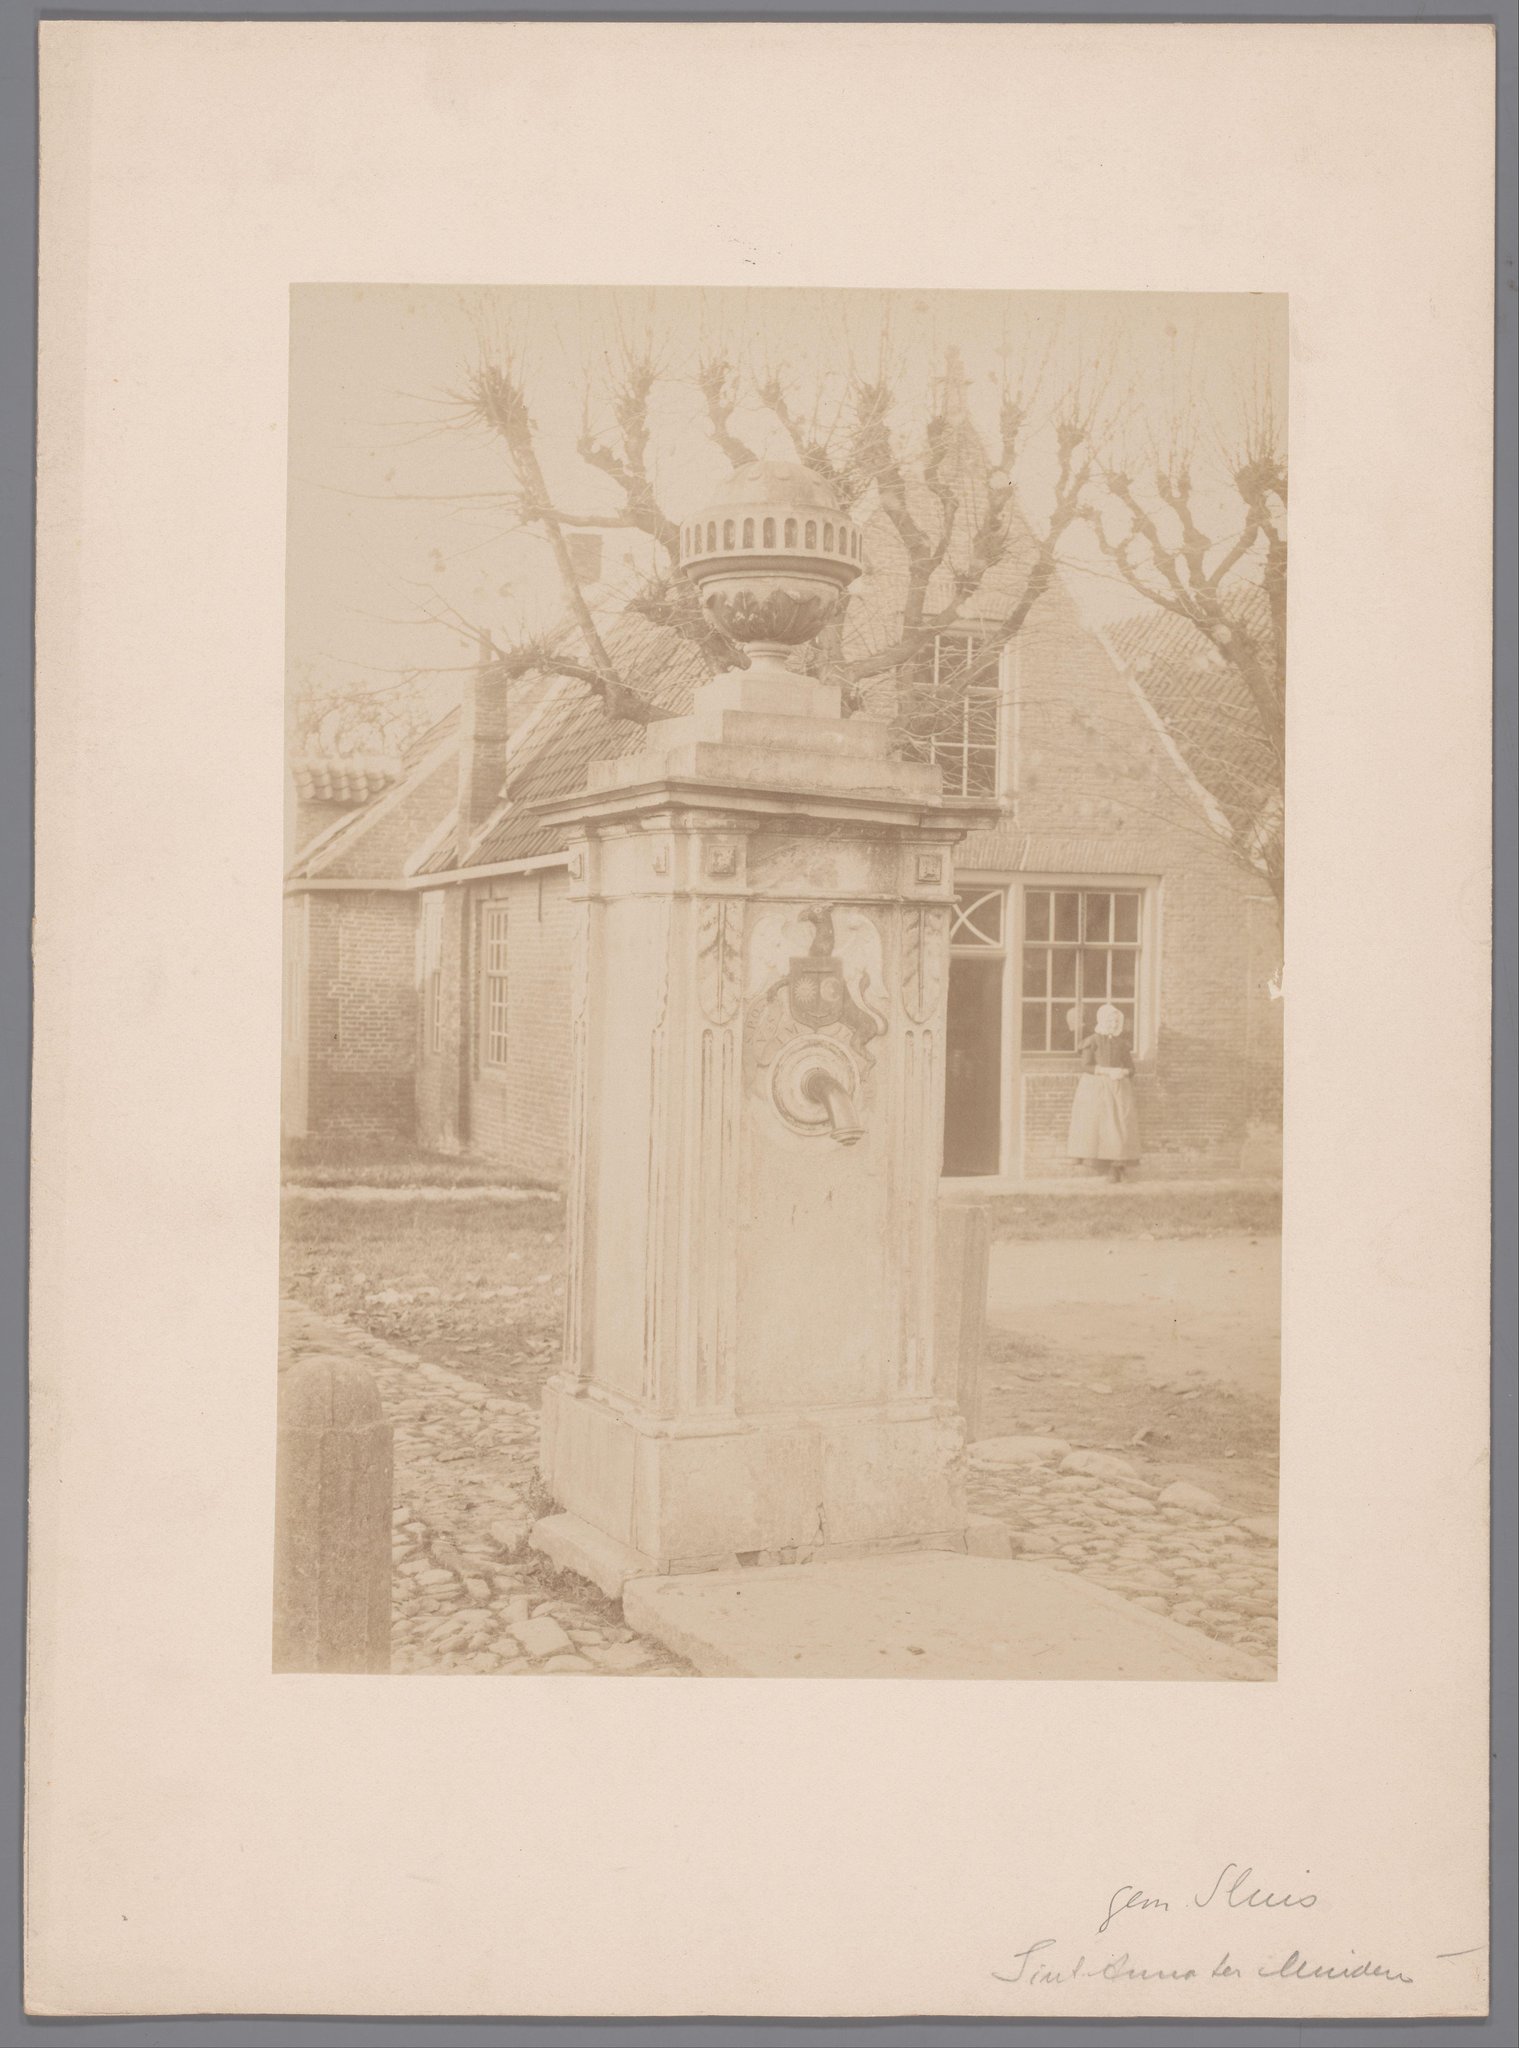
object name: photograph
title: Waterpomp te Sint Anna ter Muiden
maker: anoniem (monumentenzorg)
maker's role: fotograaf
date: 1902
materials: cardboard, photographic support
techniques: albumen print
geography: sint anna ter muiden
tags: utilitarian, public pump or water fountain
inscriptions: annotation: ‘St. Anna ter Muiden (Z.)/ Zeeland/ Pomp van 1789/ nov 1902’, annotation: ‘Gem. Sluis/ Sint Anna ter Muiden’